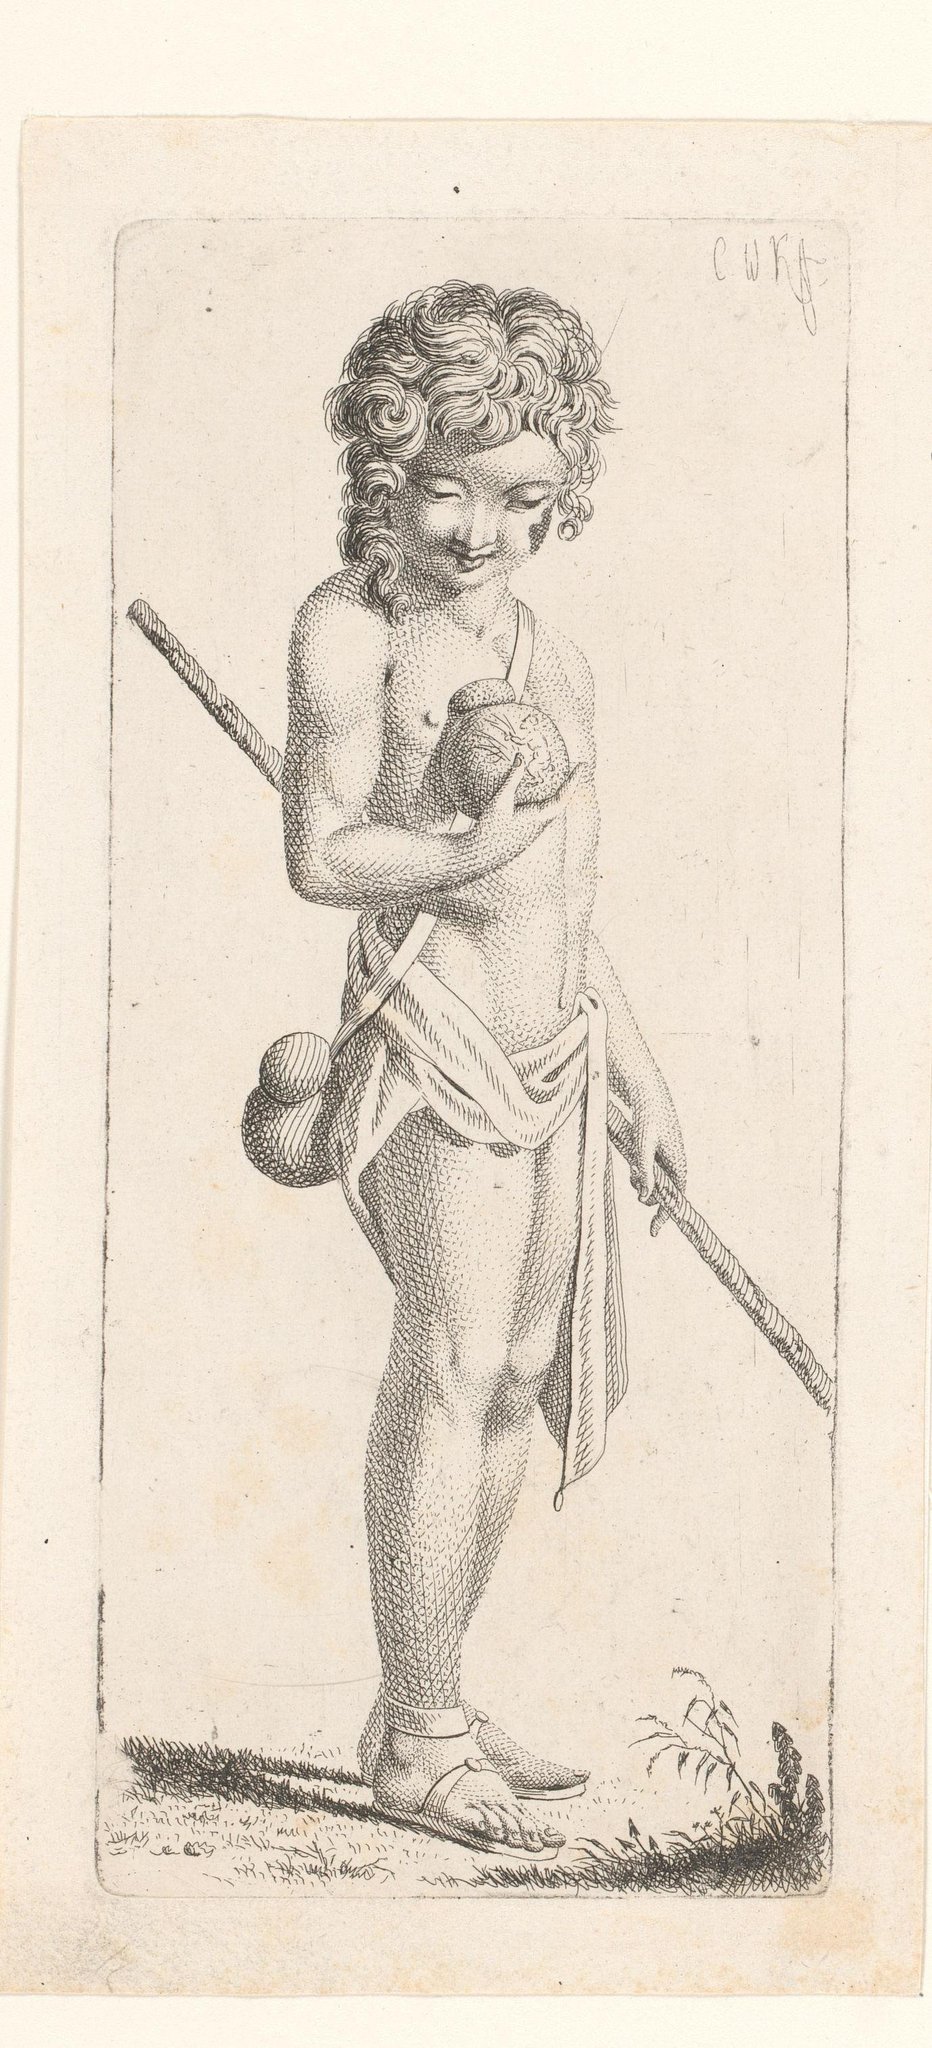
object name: print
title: Herdersjongen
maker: carl wilhelm kolbe (i)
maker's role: print maker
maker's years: 1757-1835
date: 1838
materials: paper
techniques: etching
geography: germany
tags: herding, herdsman, herdswoman, shepherd, shepherdess, cowherd, etc.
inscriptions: collector's mark: Lugt 2760, collector's mark: Lugt 2228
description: Een staande herdersjongen met staf en kruik.